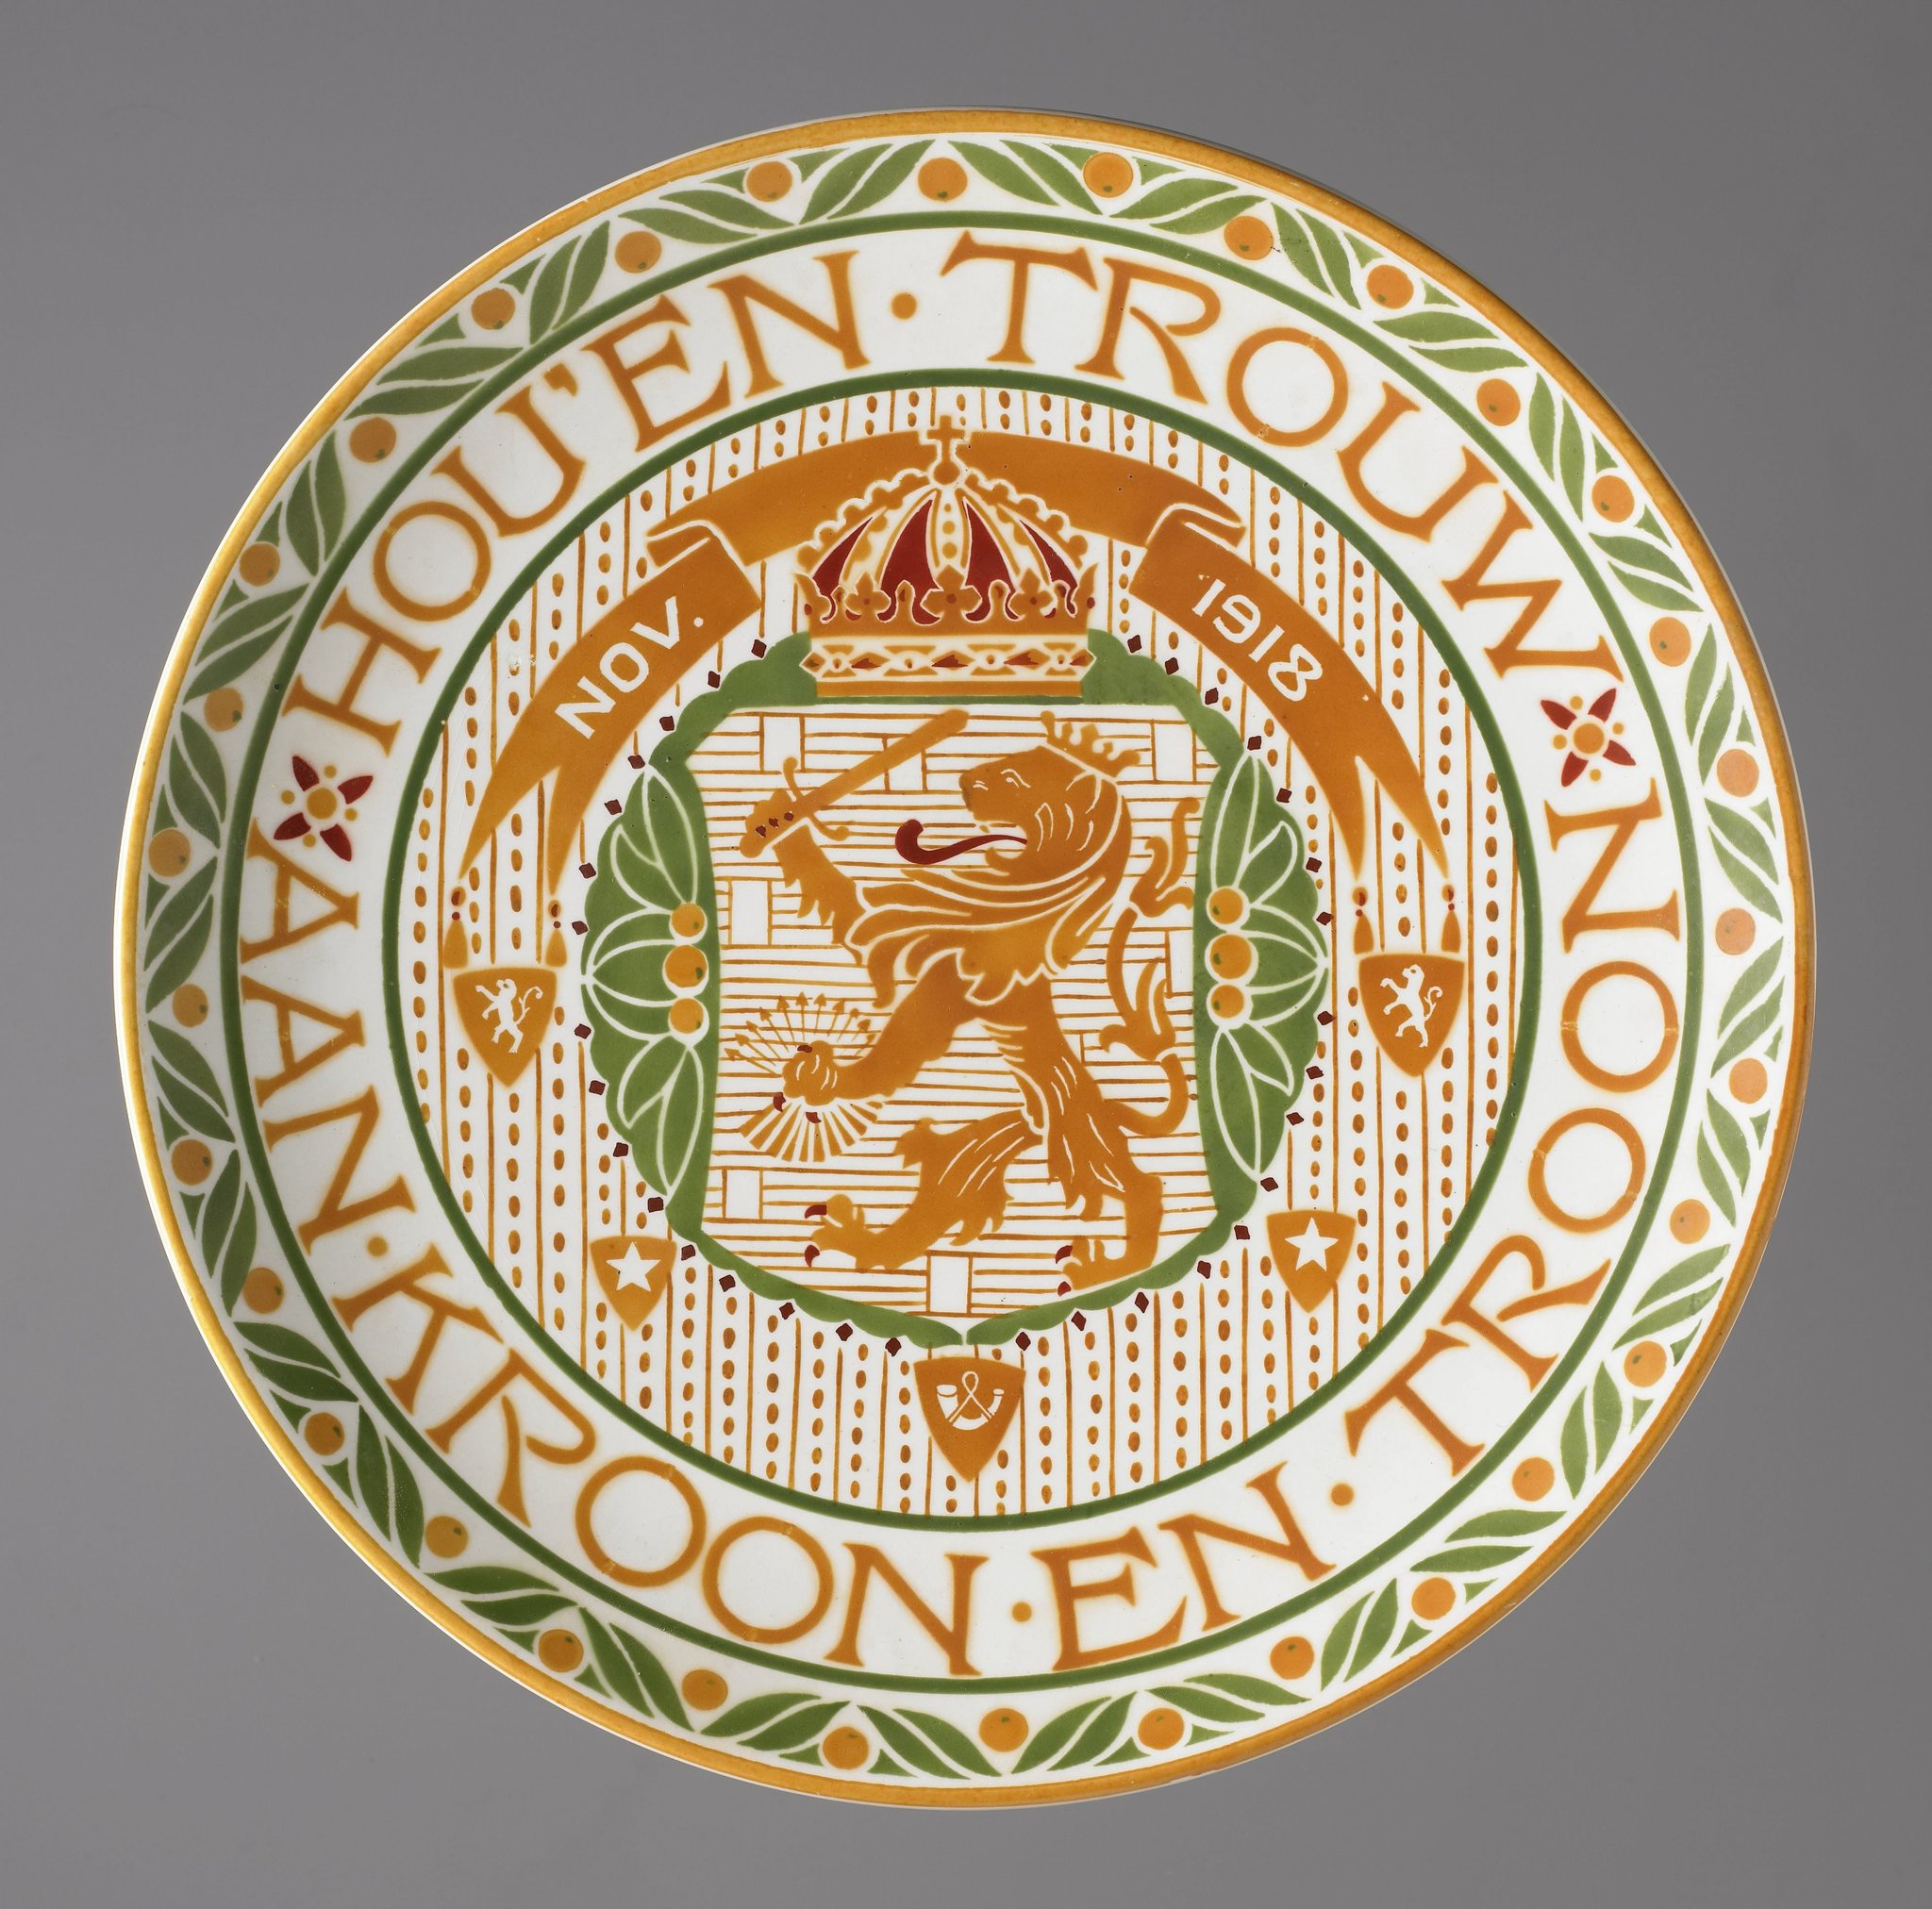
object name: commemorative plate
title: Hou'en trouw aan kroon en troon 1918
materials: earthenware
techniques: firing, vitrification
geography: maastricht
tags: politician, netherlands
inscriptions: inscription: ‘HOU'EN.TROUW AAN.KROON.EN.TROON’, mark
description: Herdenkingsbord met de kleuren oranje, groen en donkerrood. Rand van oranje-appeltjes met gestileerde bladeren en rondschrift. Op het plat nederlandse leeuw waarboven een kroon en een wimpel geflankeerd door oranje-appeltjes met bladeren en 5 wapentjes (2 sterren, 2 leeuwen en een posthoorn) op een ondergrond van stippen en strepen.